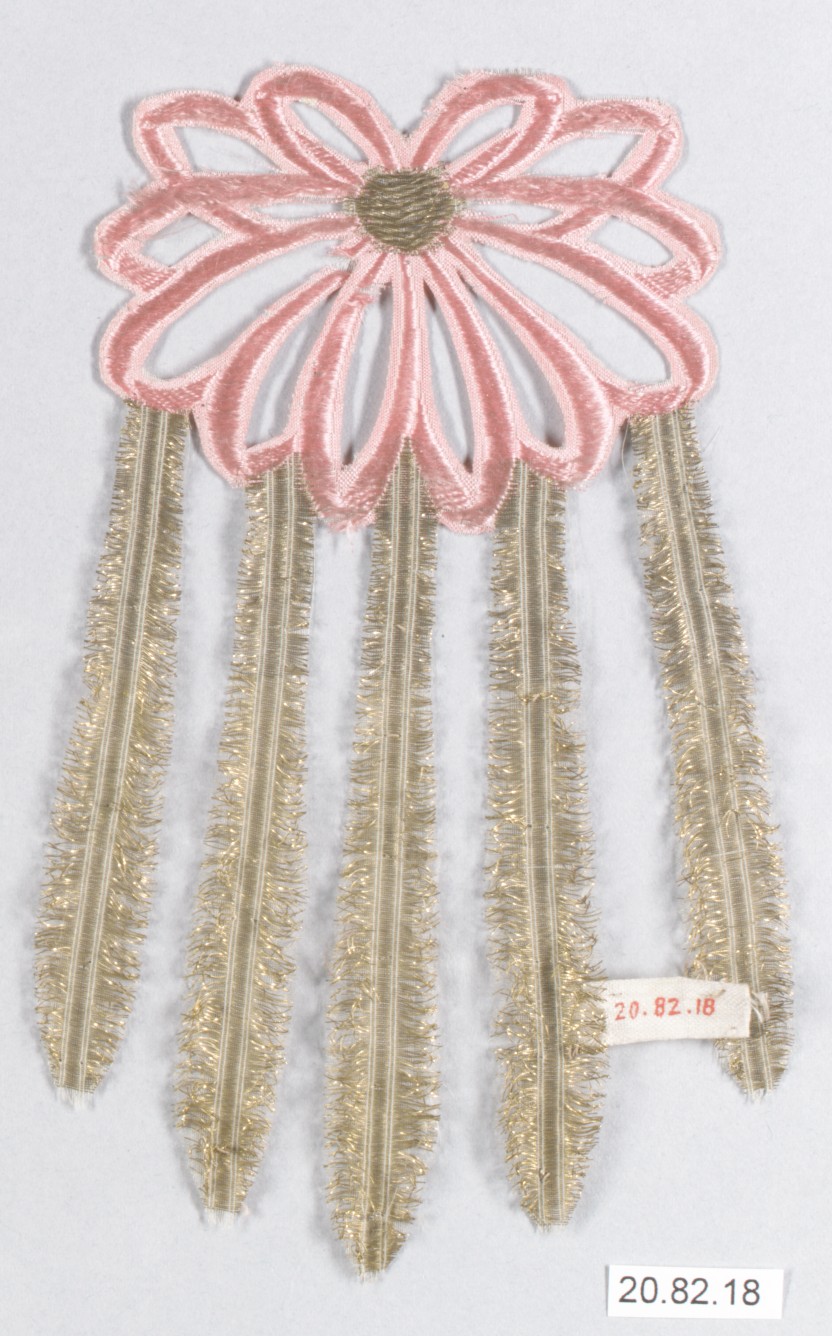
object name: passementerie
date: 1801-1833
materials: metal thread, silk